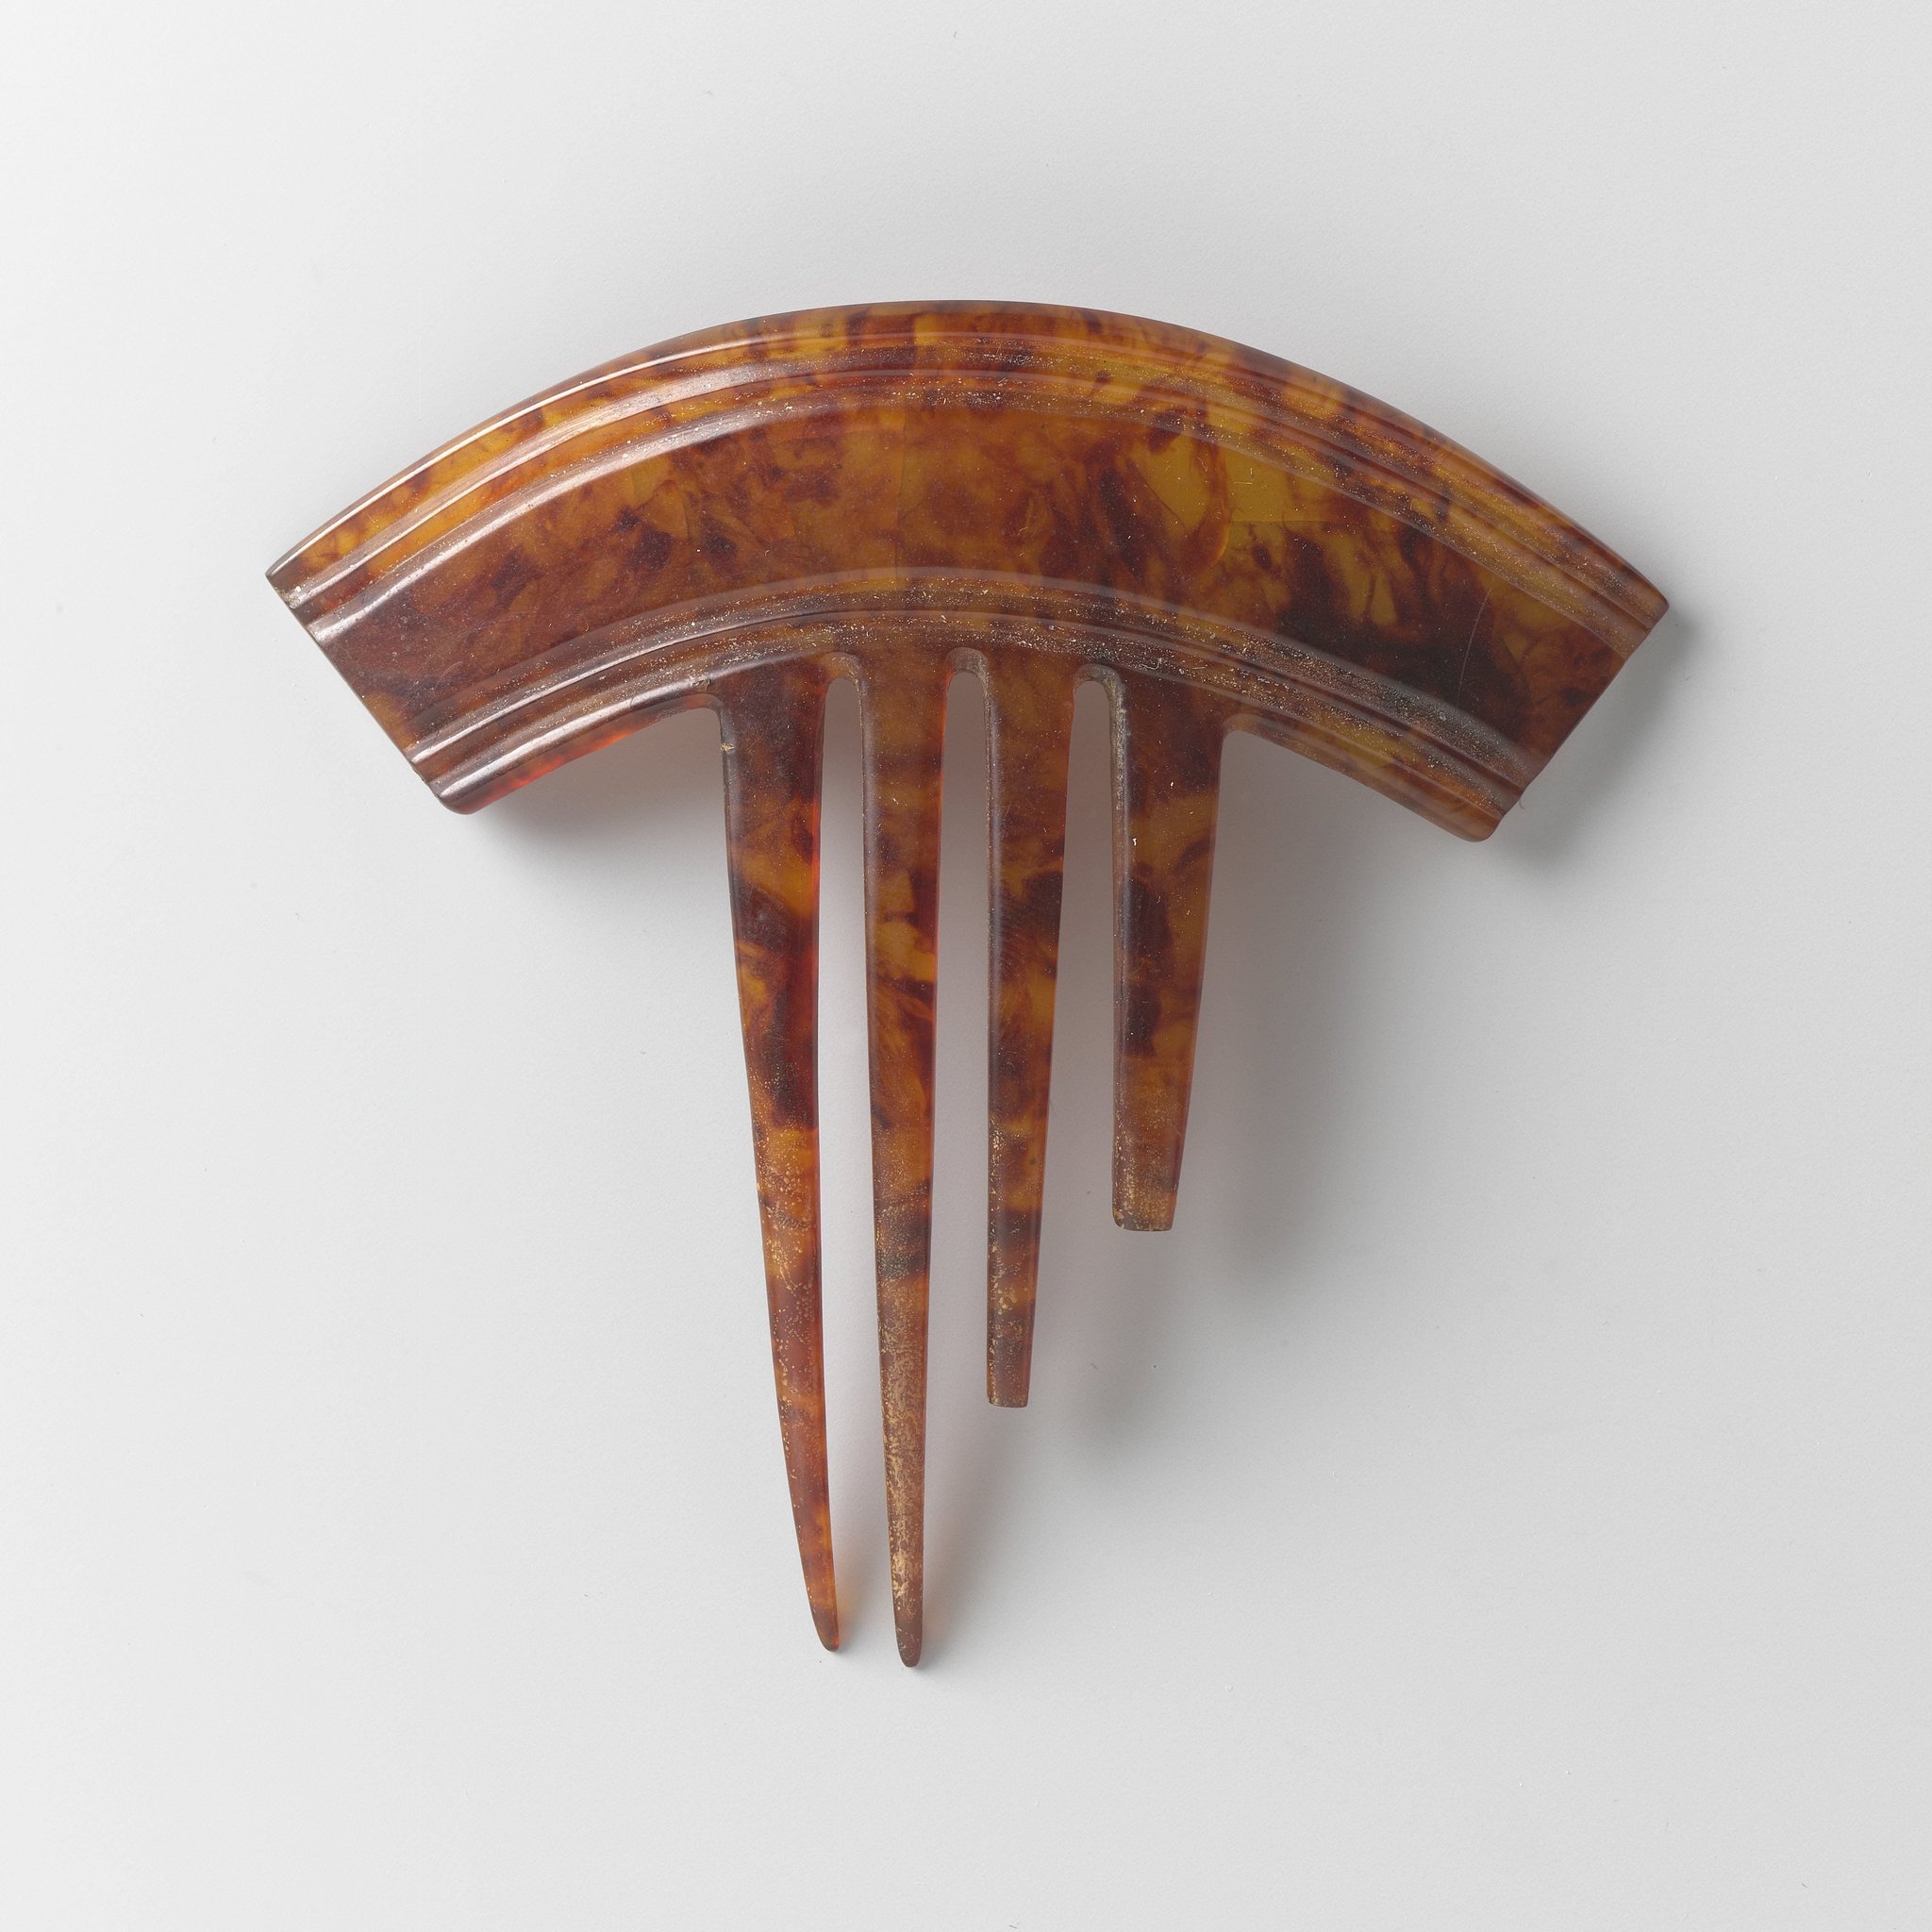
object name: comb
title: Haarkam van imitatie schildpad met gladde, paraboolvormige rug, vier tanden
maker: Anonymous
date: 1800-1825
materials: celluloid, plastic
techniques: filing, polish, pressing, sawing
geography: netherlands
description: Haarkam van imitatie schildpad met gladde, paraboolvormige rug waarin twee banen in reliëf. Vier tanden.